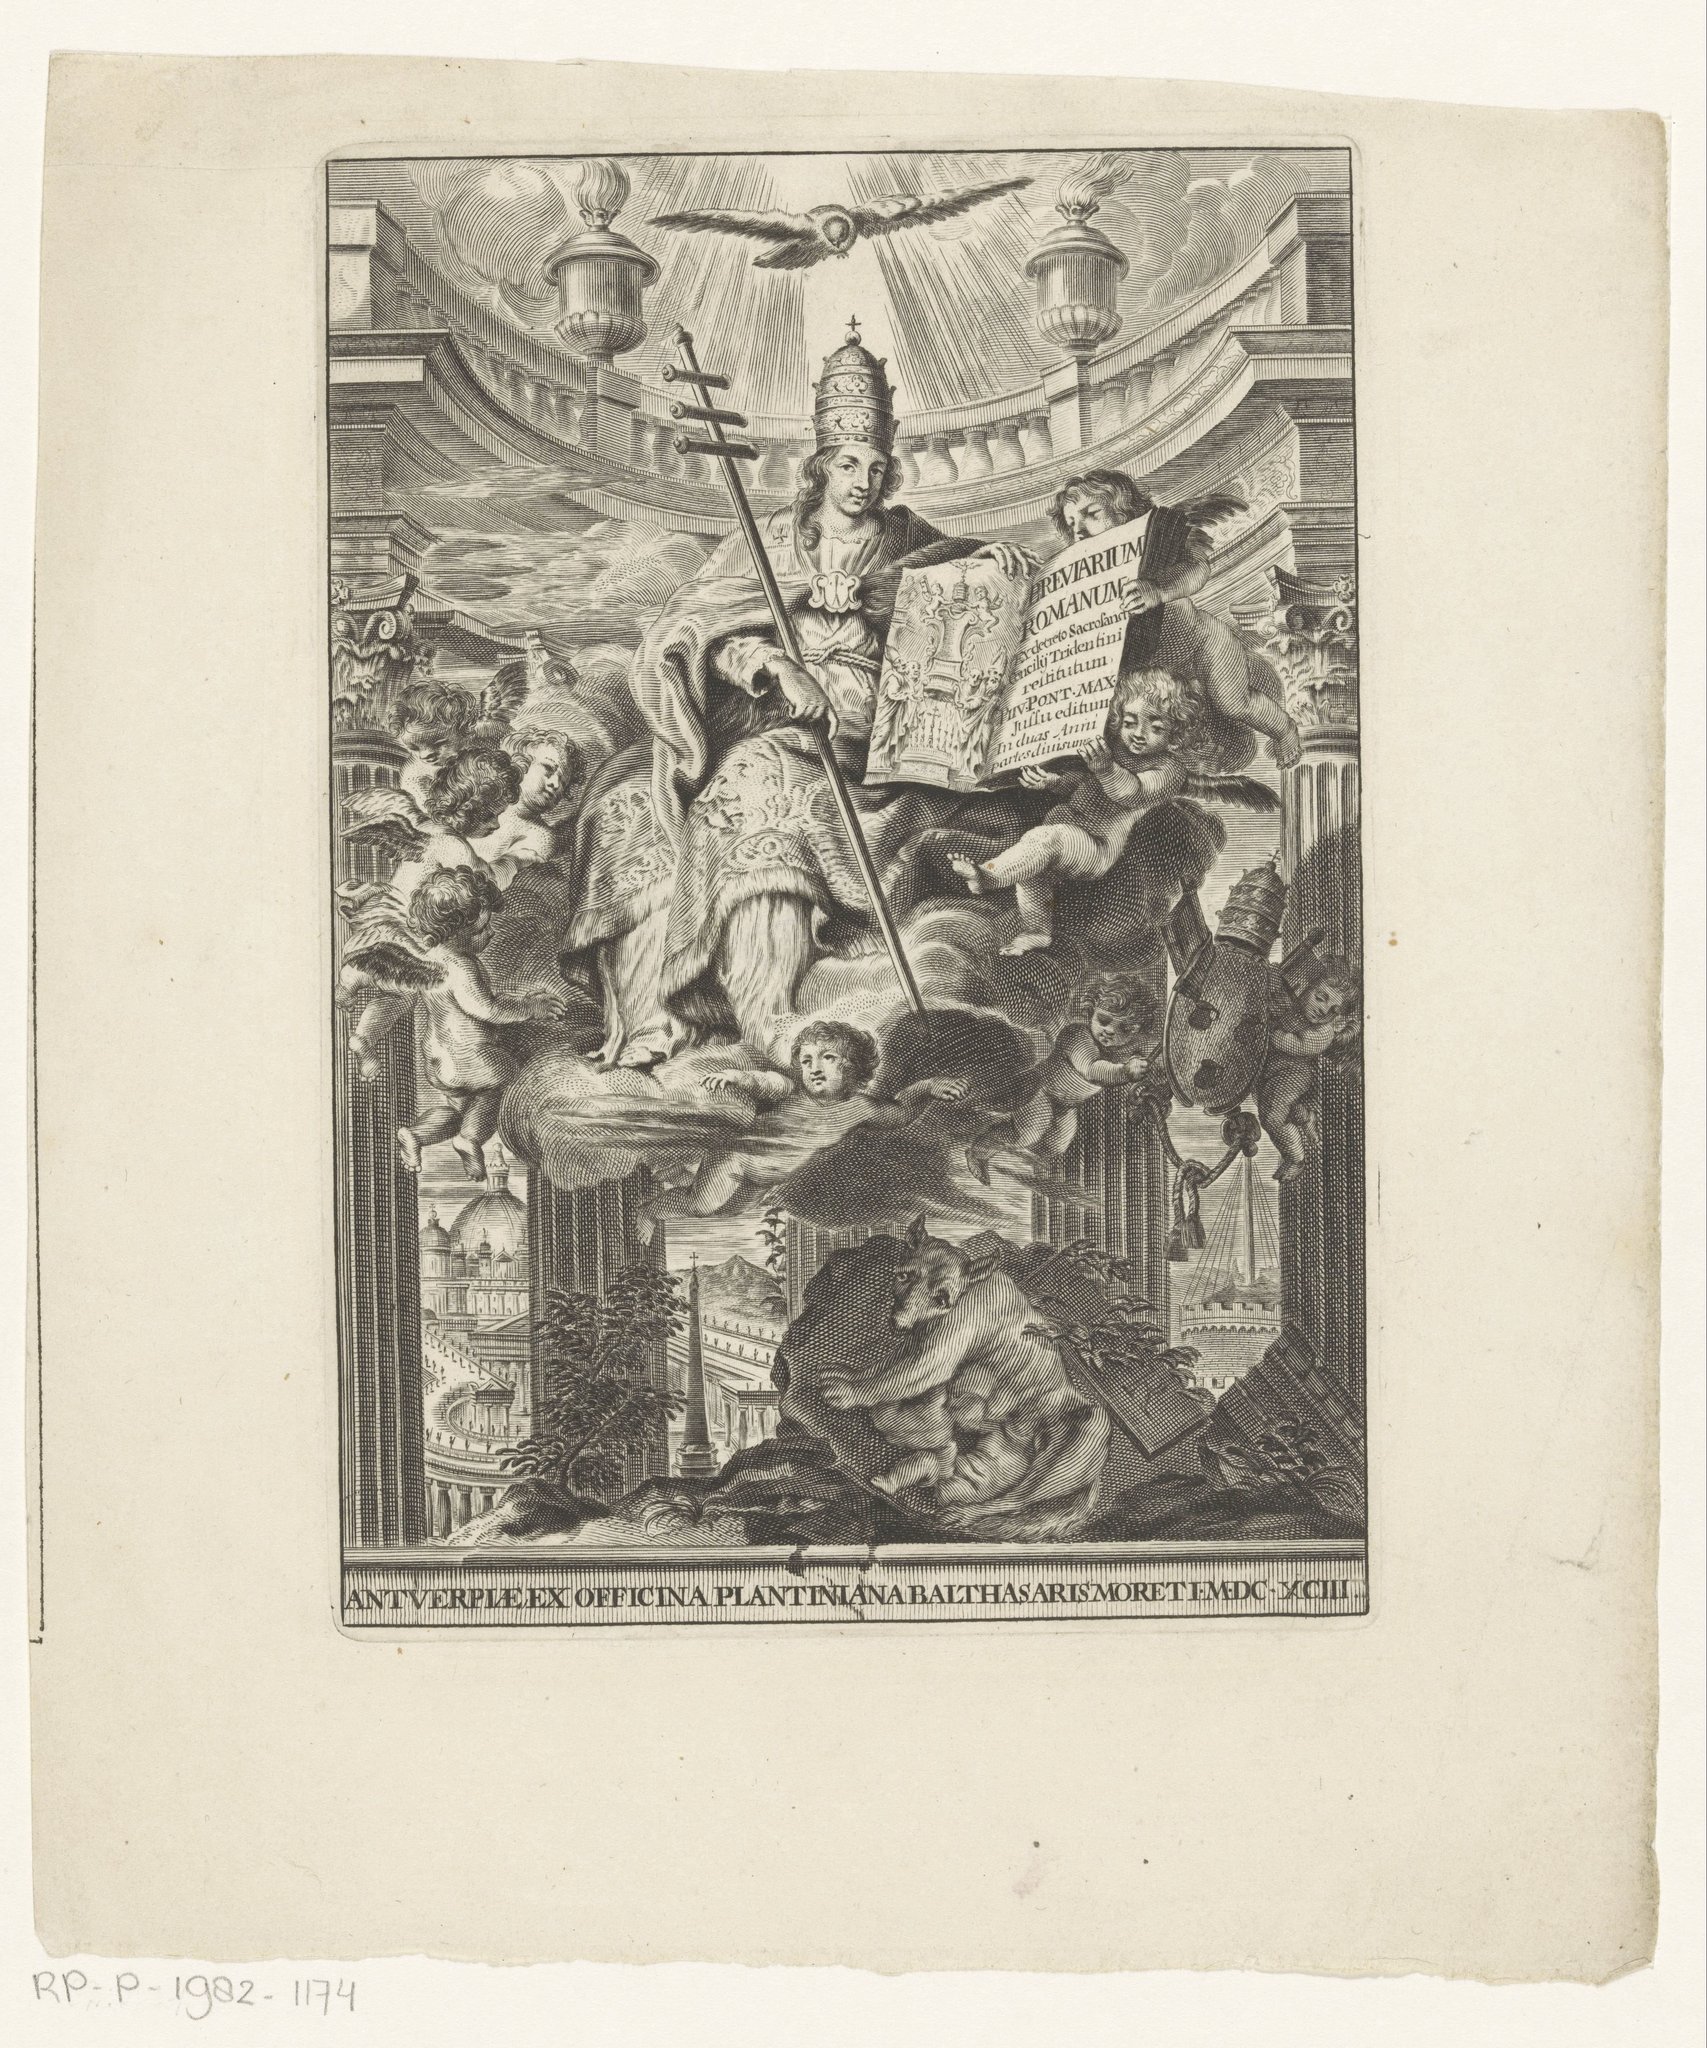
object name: titelblad, titelpagina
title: Allegorische voorstelling met personificatie van de Rooms-katholieke kerk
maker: martin bouche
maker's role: print maker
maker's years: 1640-1693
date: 1693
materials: paper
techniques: engraving, etching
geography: antwerp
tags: triumph of the church (or religion), insignia of the pope, e.g. tiara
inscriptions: date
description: De personificatie van de Rooms-katholieke kerk met bisschopsstaf, pauselijke tiara en een boek met altaar en de titel van het boek, omgeven door putti. Boven haar een duif als symbool van de heilige geest. Rechts twee putti met een pauselijk wapenschild. Aan de onderzijde Romulus en Remus en de wolvin.